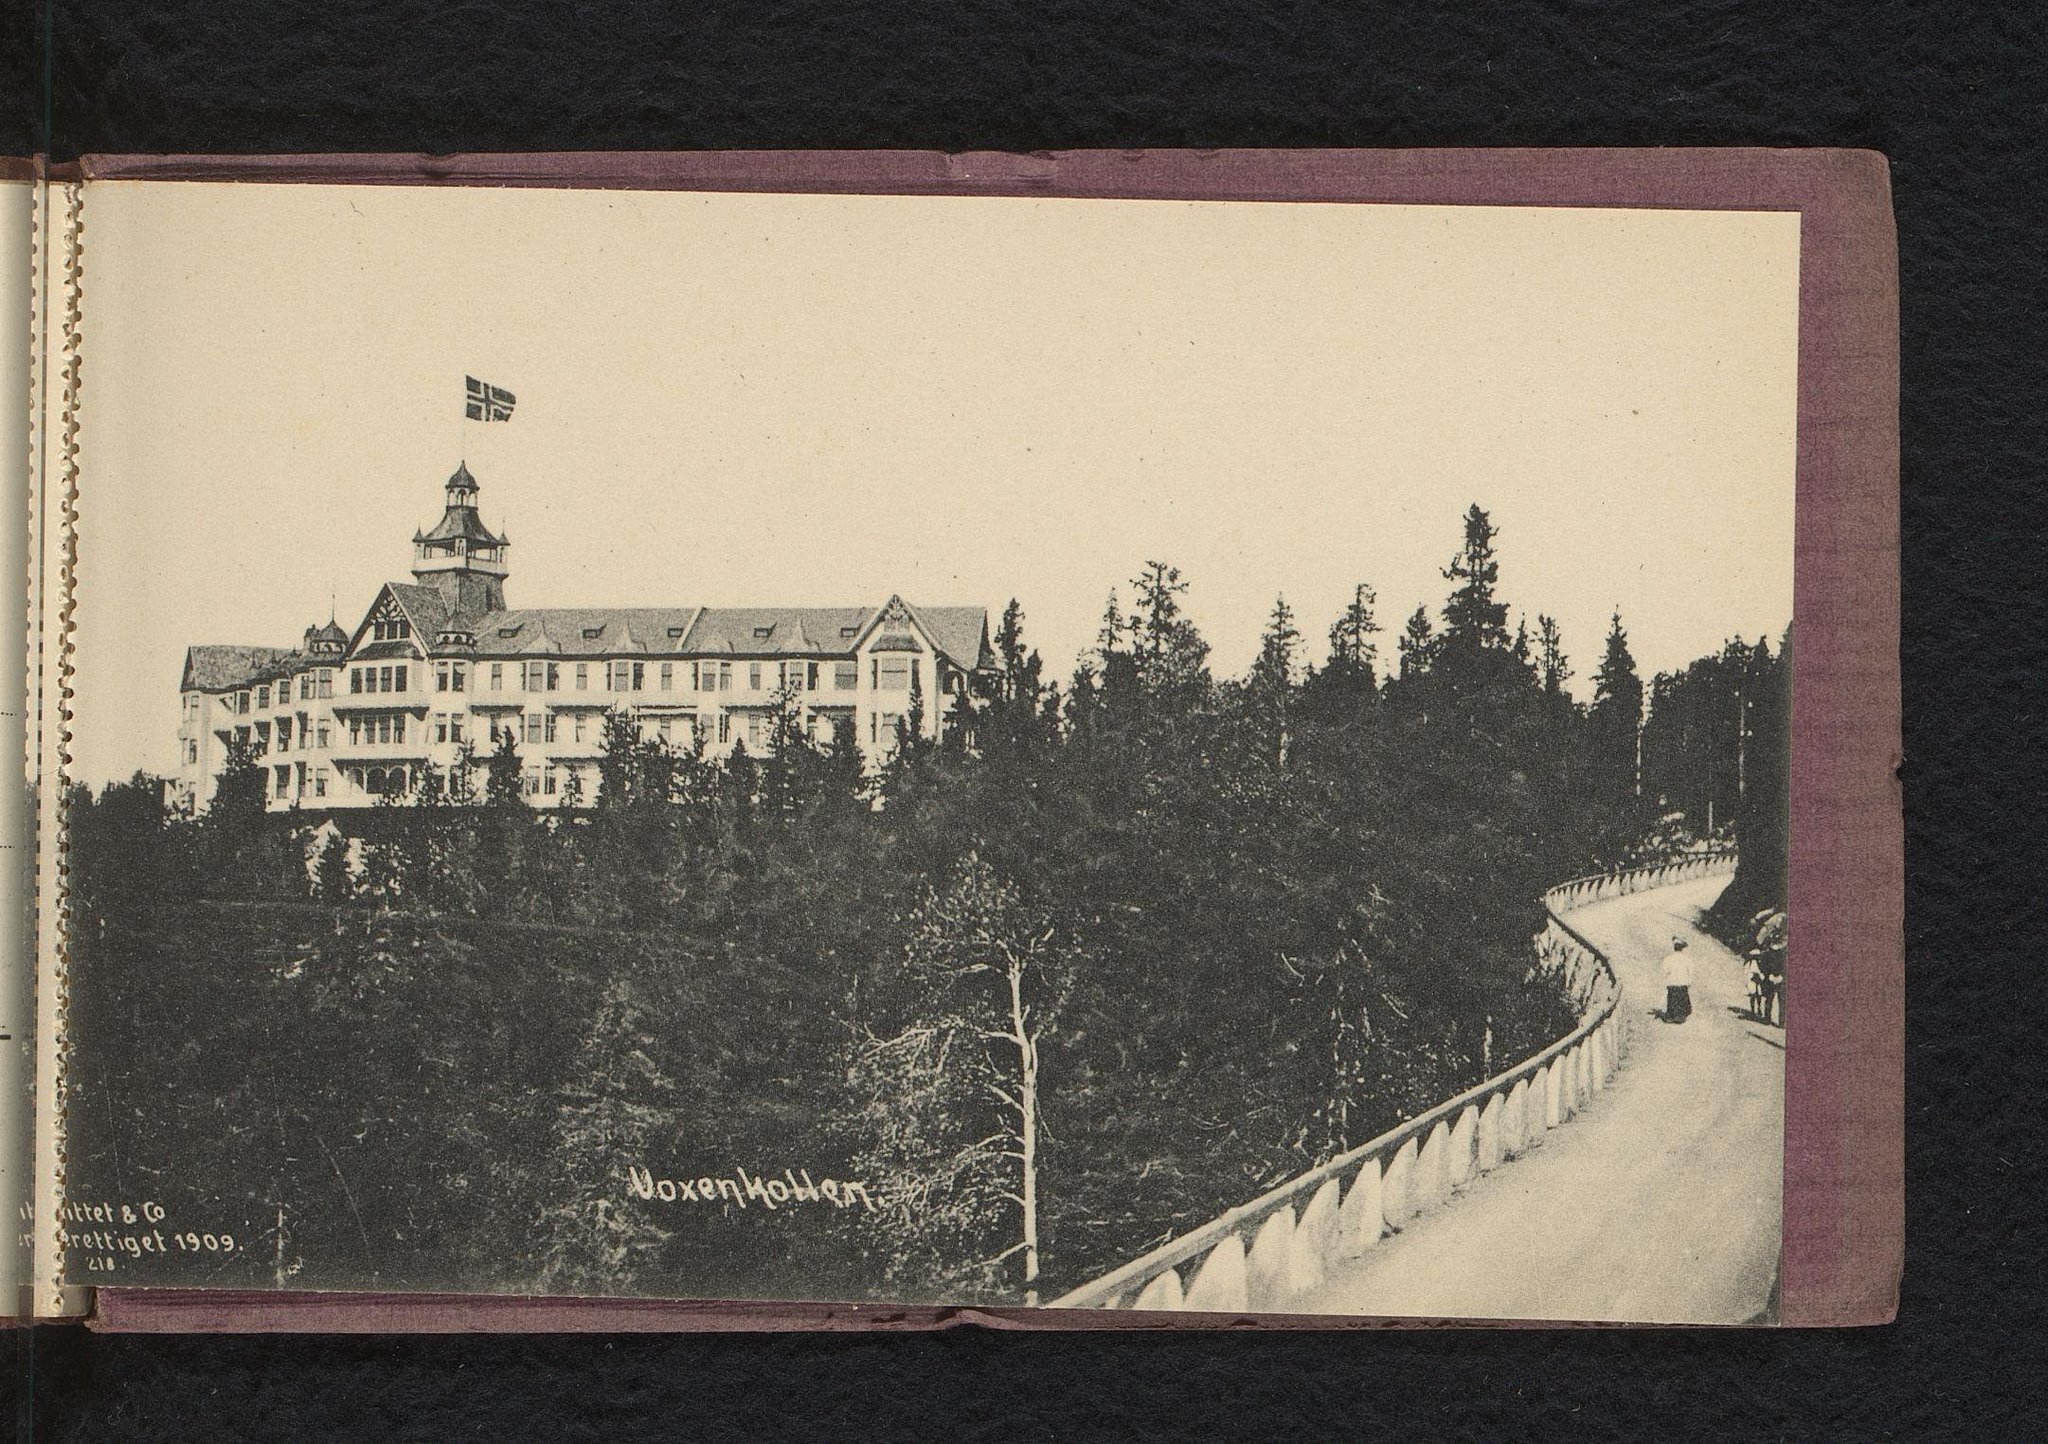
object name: ansichtkaart, prentbriefkaart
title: Voxenkollen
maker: Anonymous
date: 1909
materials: cardboard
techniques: photograph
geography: oslo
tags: city-view, and landscape with man-made constructions, public road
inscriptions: date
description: Prentbriefkaart maakt deel uit van een album.